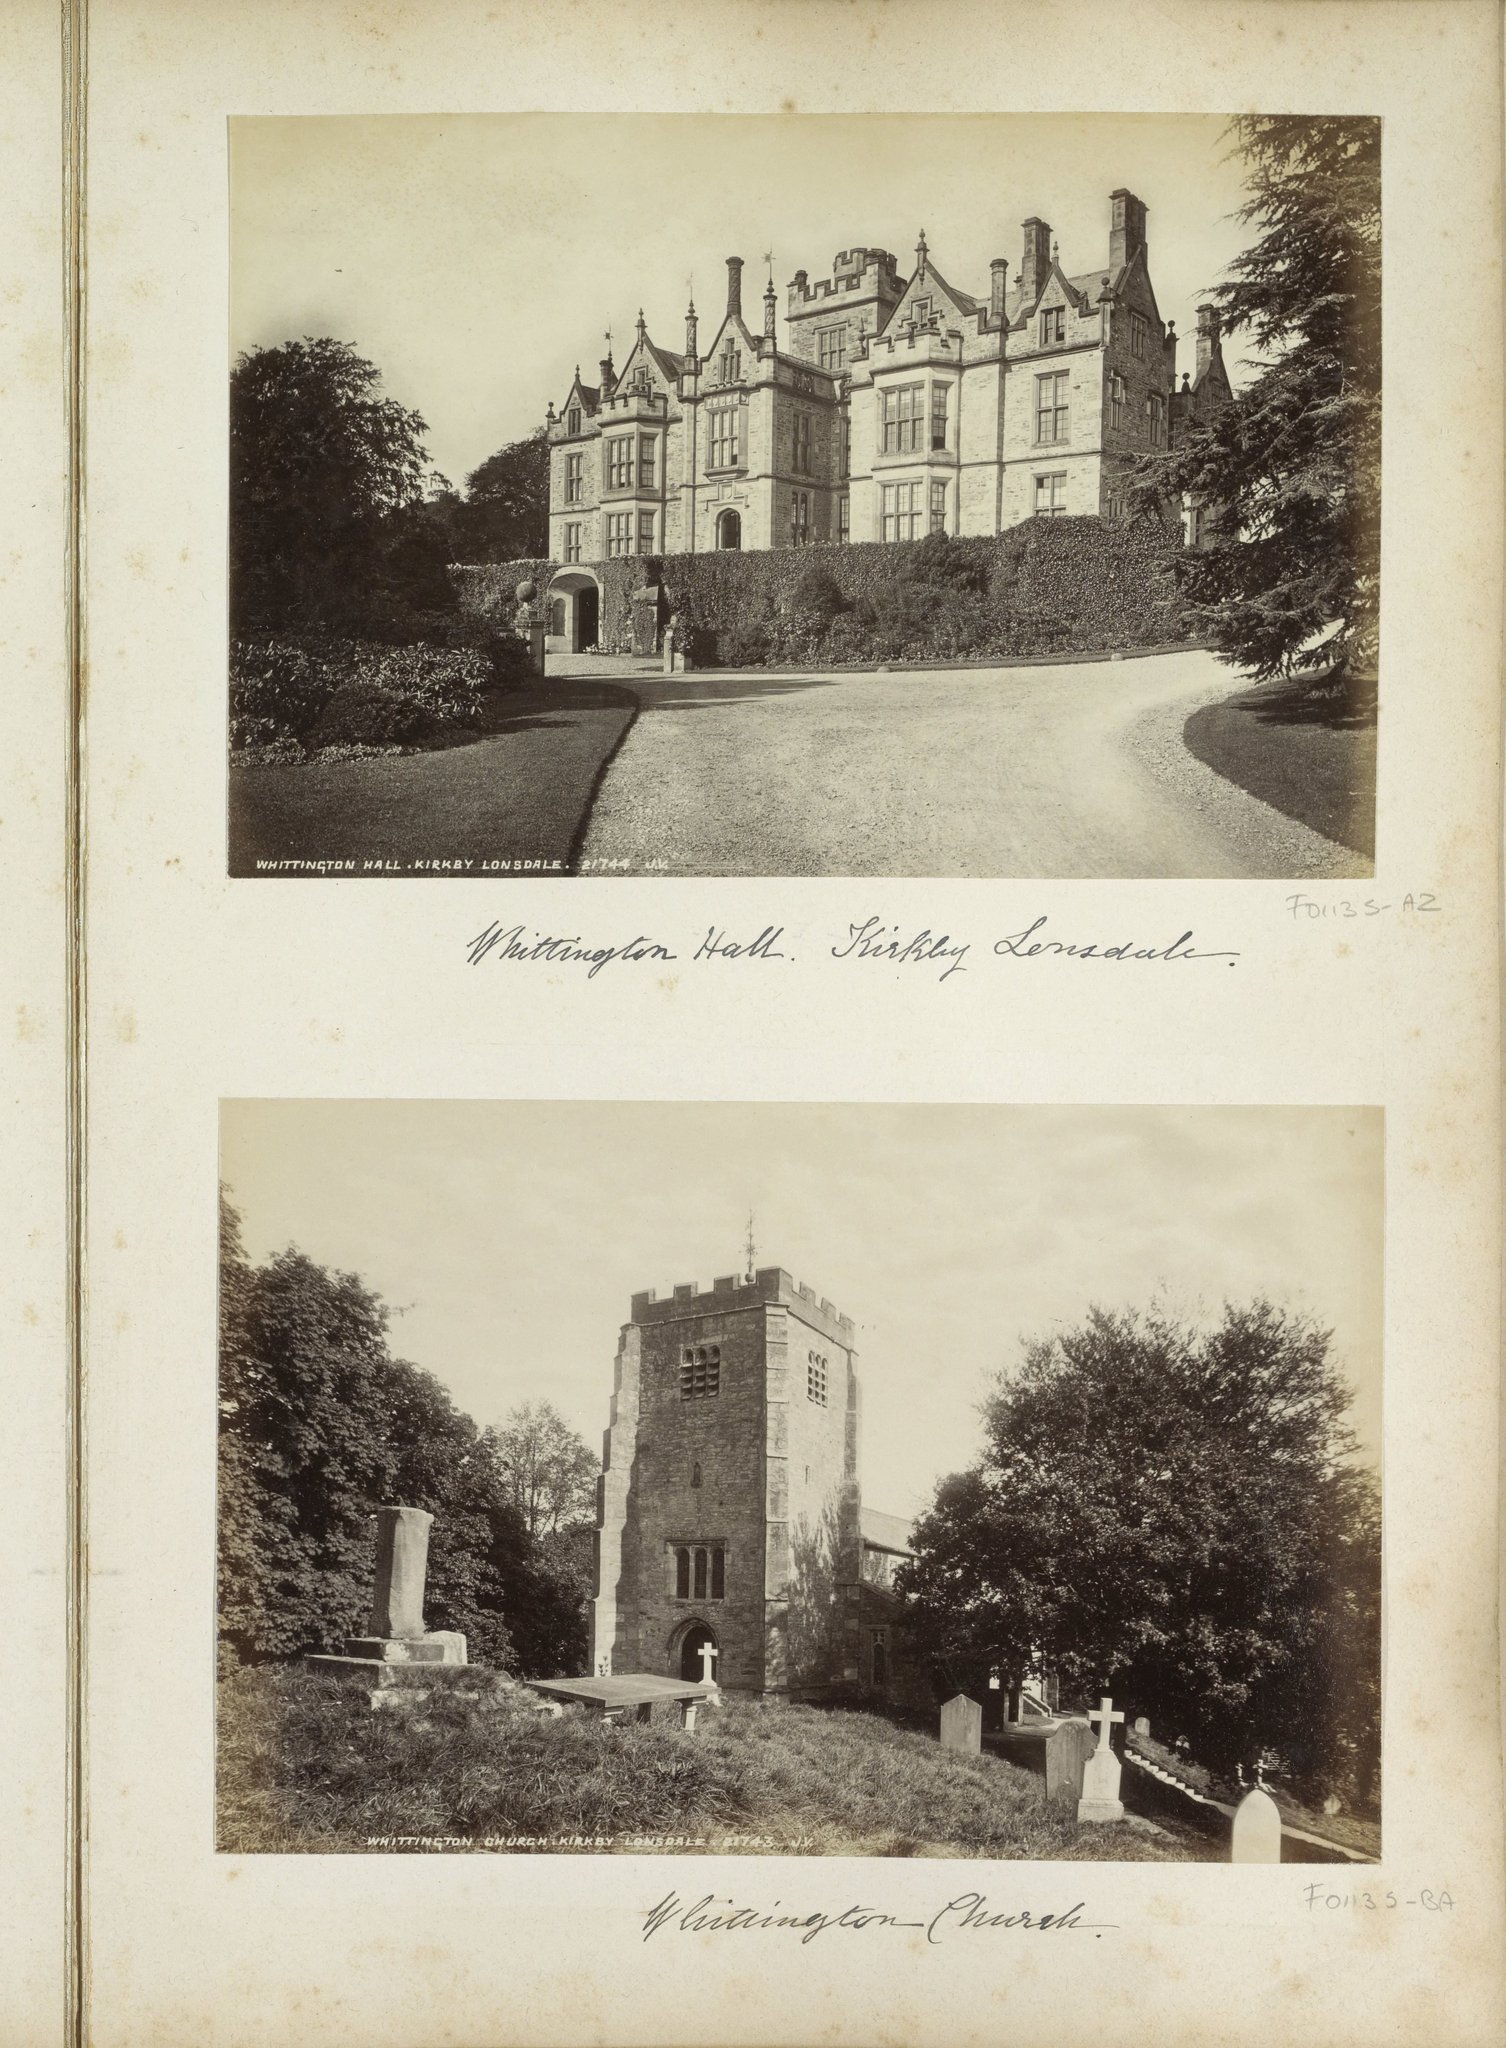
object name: album leaf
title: Whittington Church. Kirkby Lonsdale.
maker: james valentine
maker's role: fotograaf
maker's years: 1815-1880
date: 1899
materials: paper, photographic support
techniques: albumen print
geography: kirkby lonsdale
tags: church (exterior), churchyard, cemetery, parts of church exterior and annexes: tower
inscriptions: negative number: ‘21743’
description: Onderdeel van Reisalbum met foto's van bezienswaardigheden in Engeland en Frankrijk.